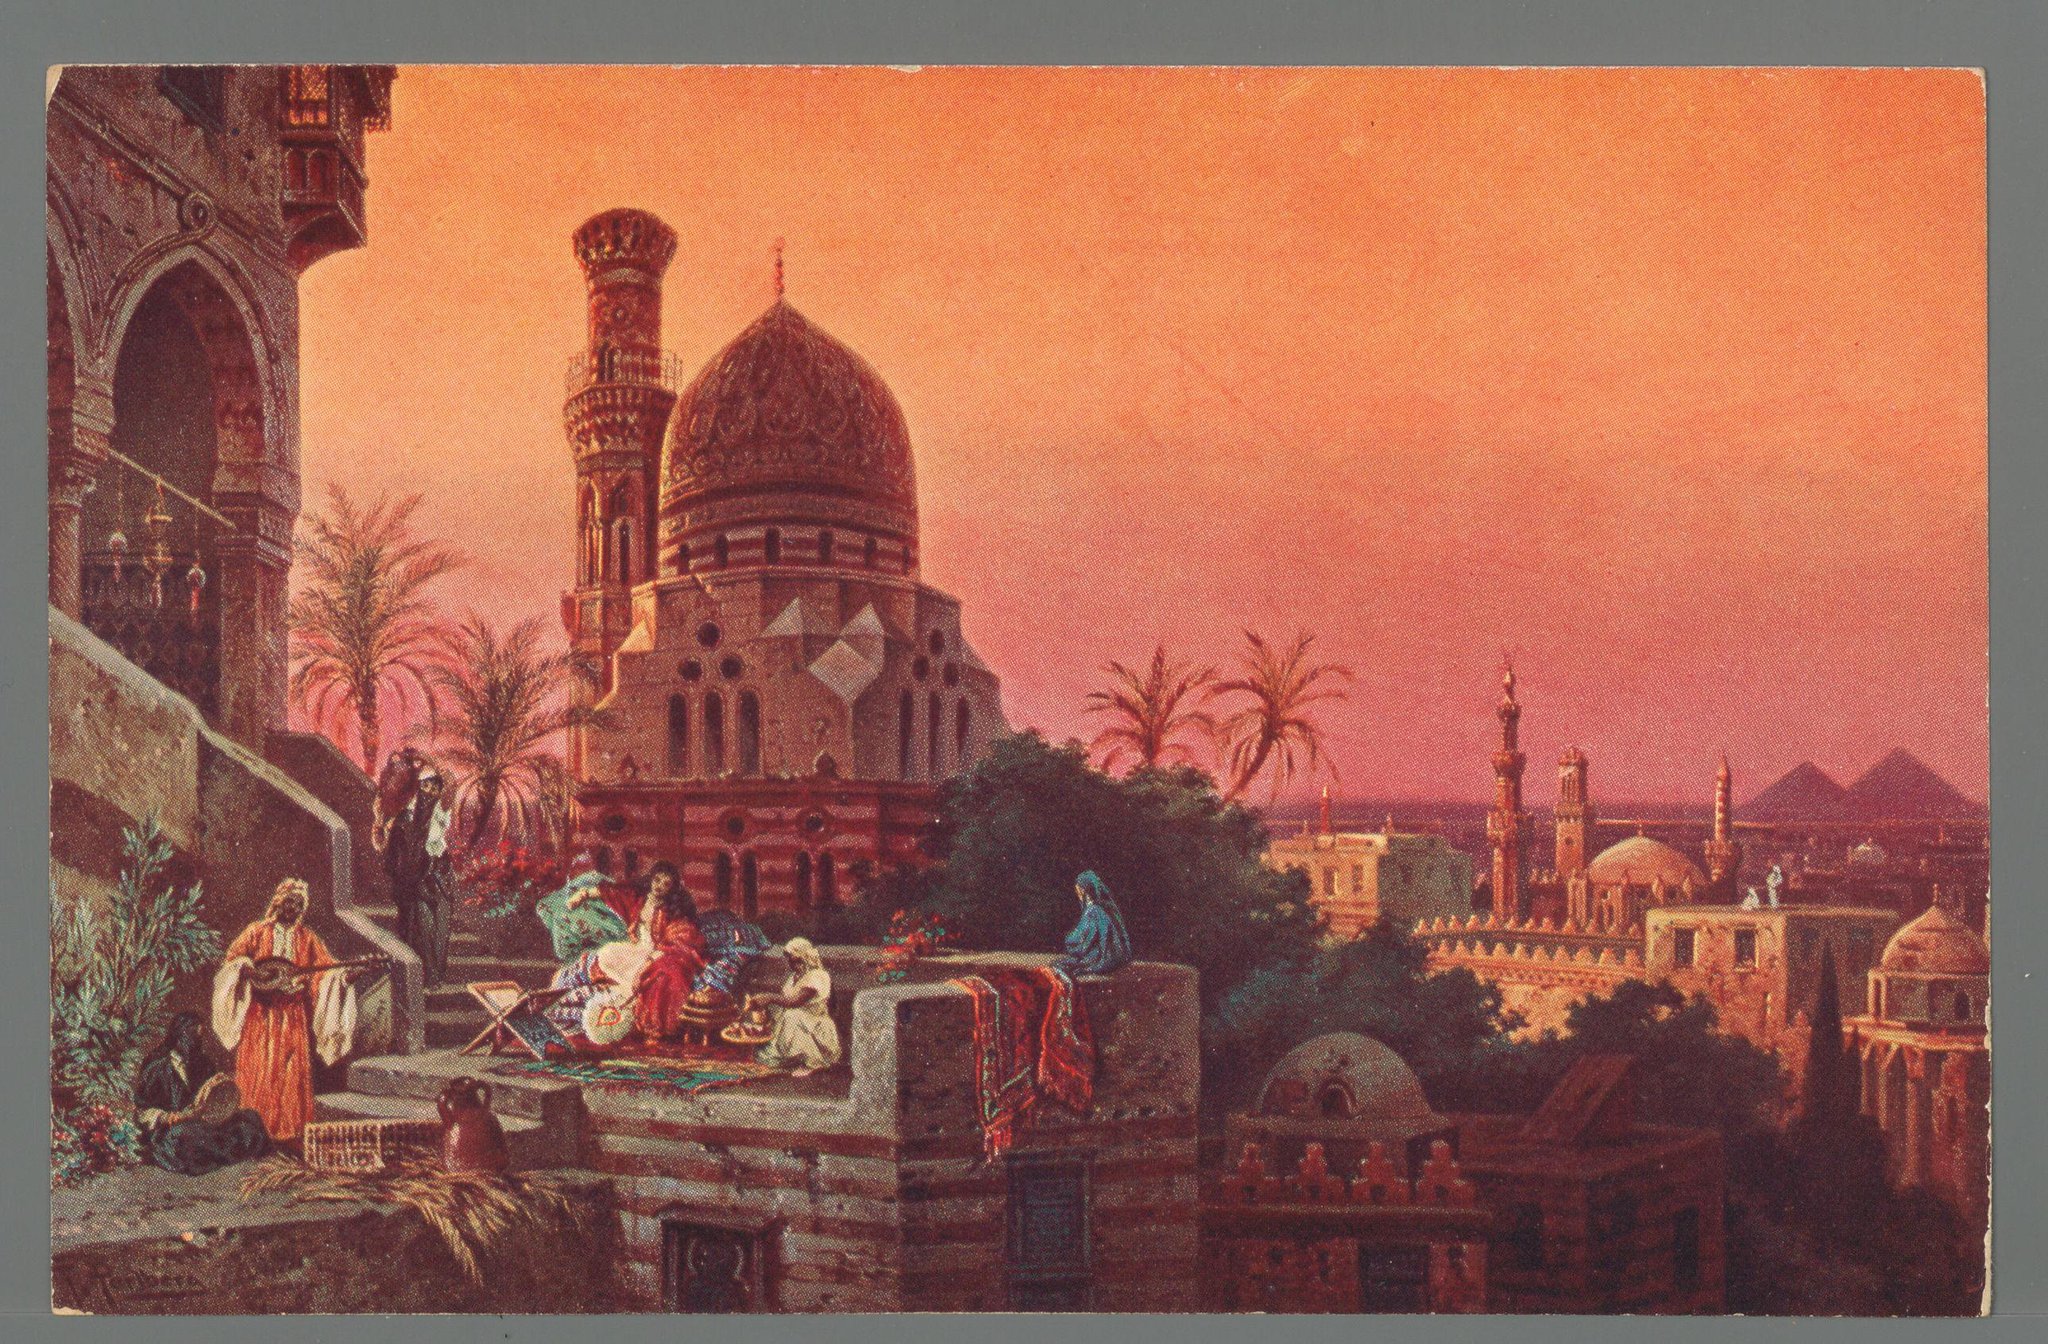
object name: reproduction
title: Le Caire / Cairo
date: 1907-1930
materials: cardboard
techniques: color autotype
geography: dresden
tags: city-view, and landscape with man-made constructions, quadrangular pyramid, temple, shrine ~ islam, mohammedanism